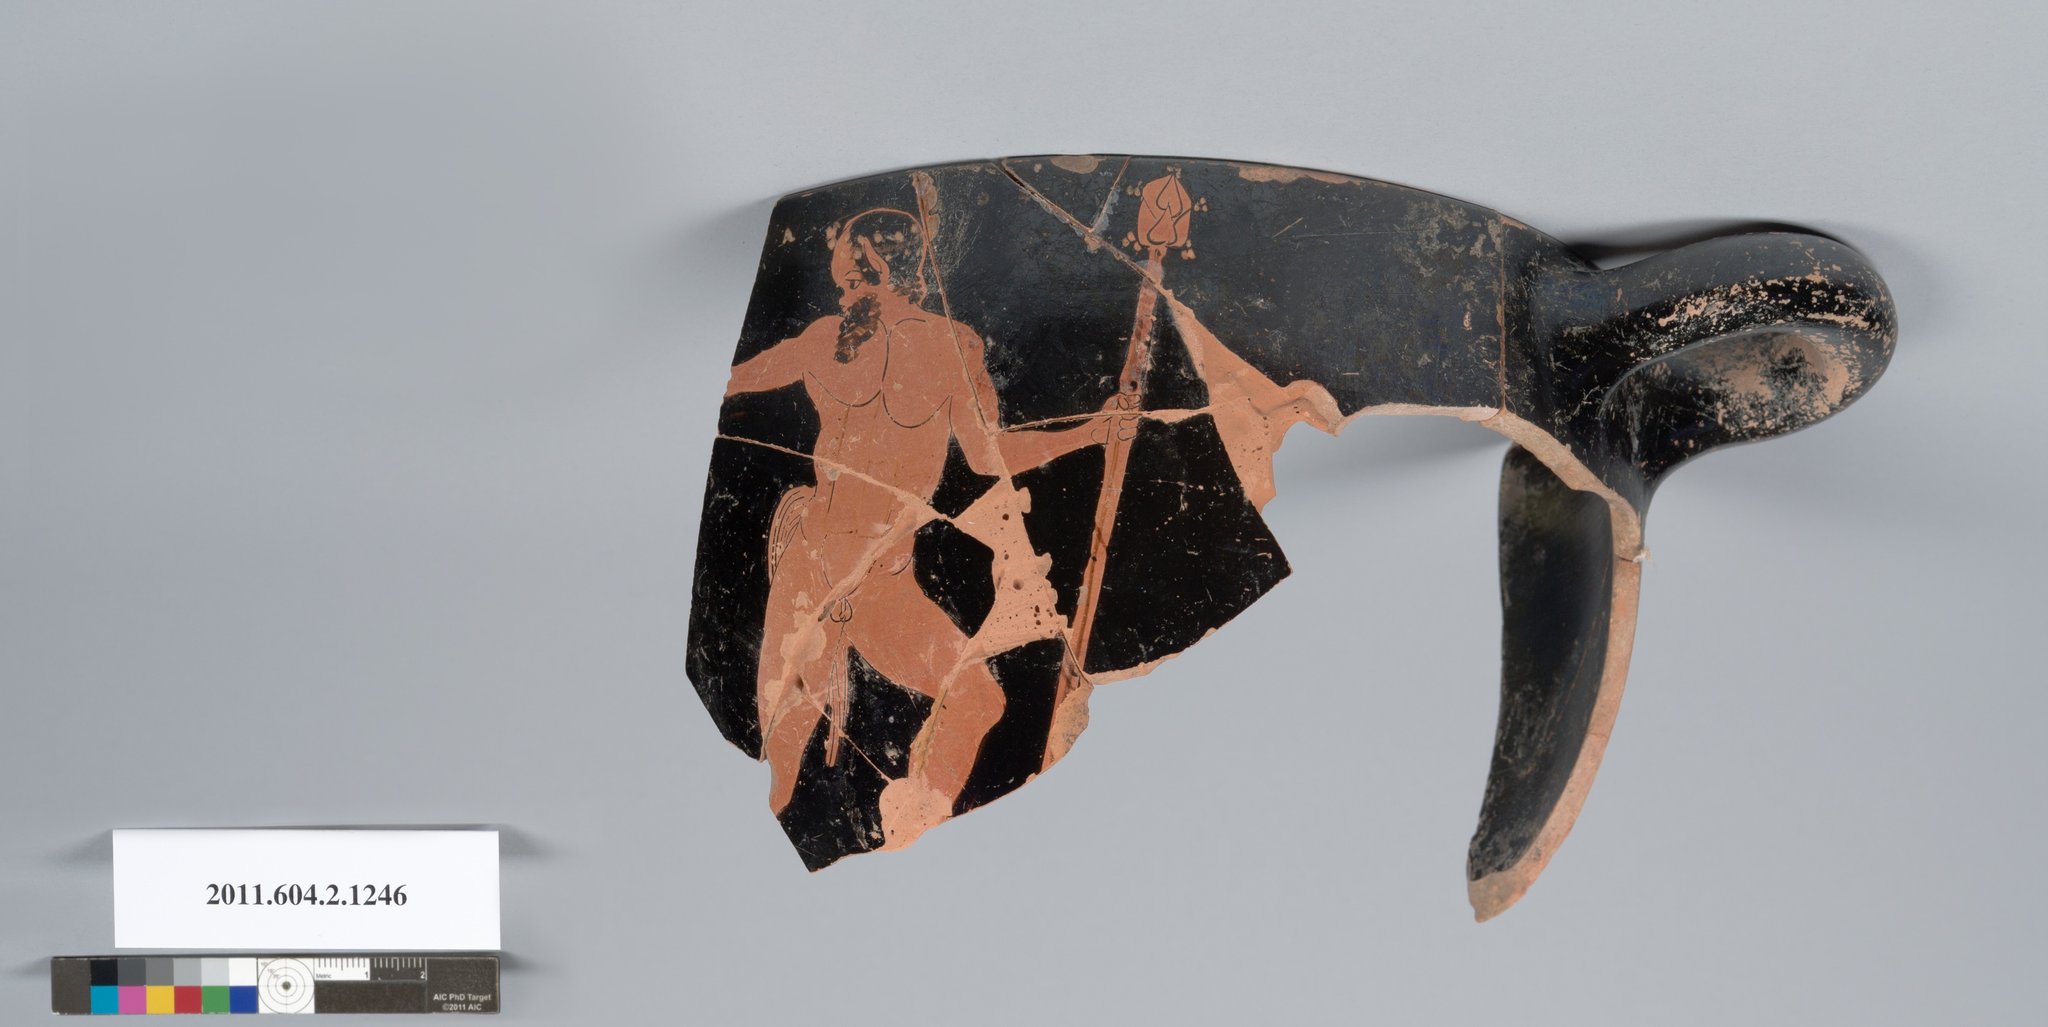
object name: skyphos fragment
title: Terracotta fragment of a skyphos (deep drinking cup)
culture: greek, attic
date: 450-440 BCE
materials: terracotta